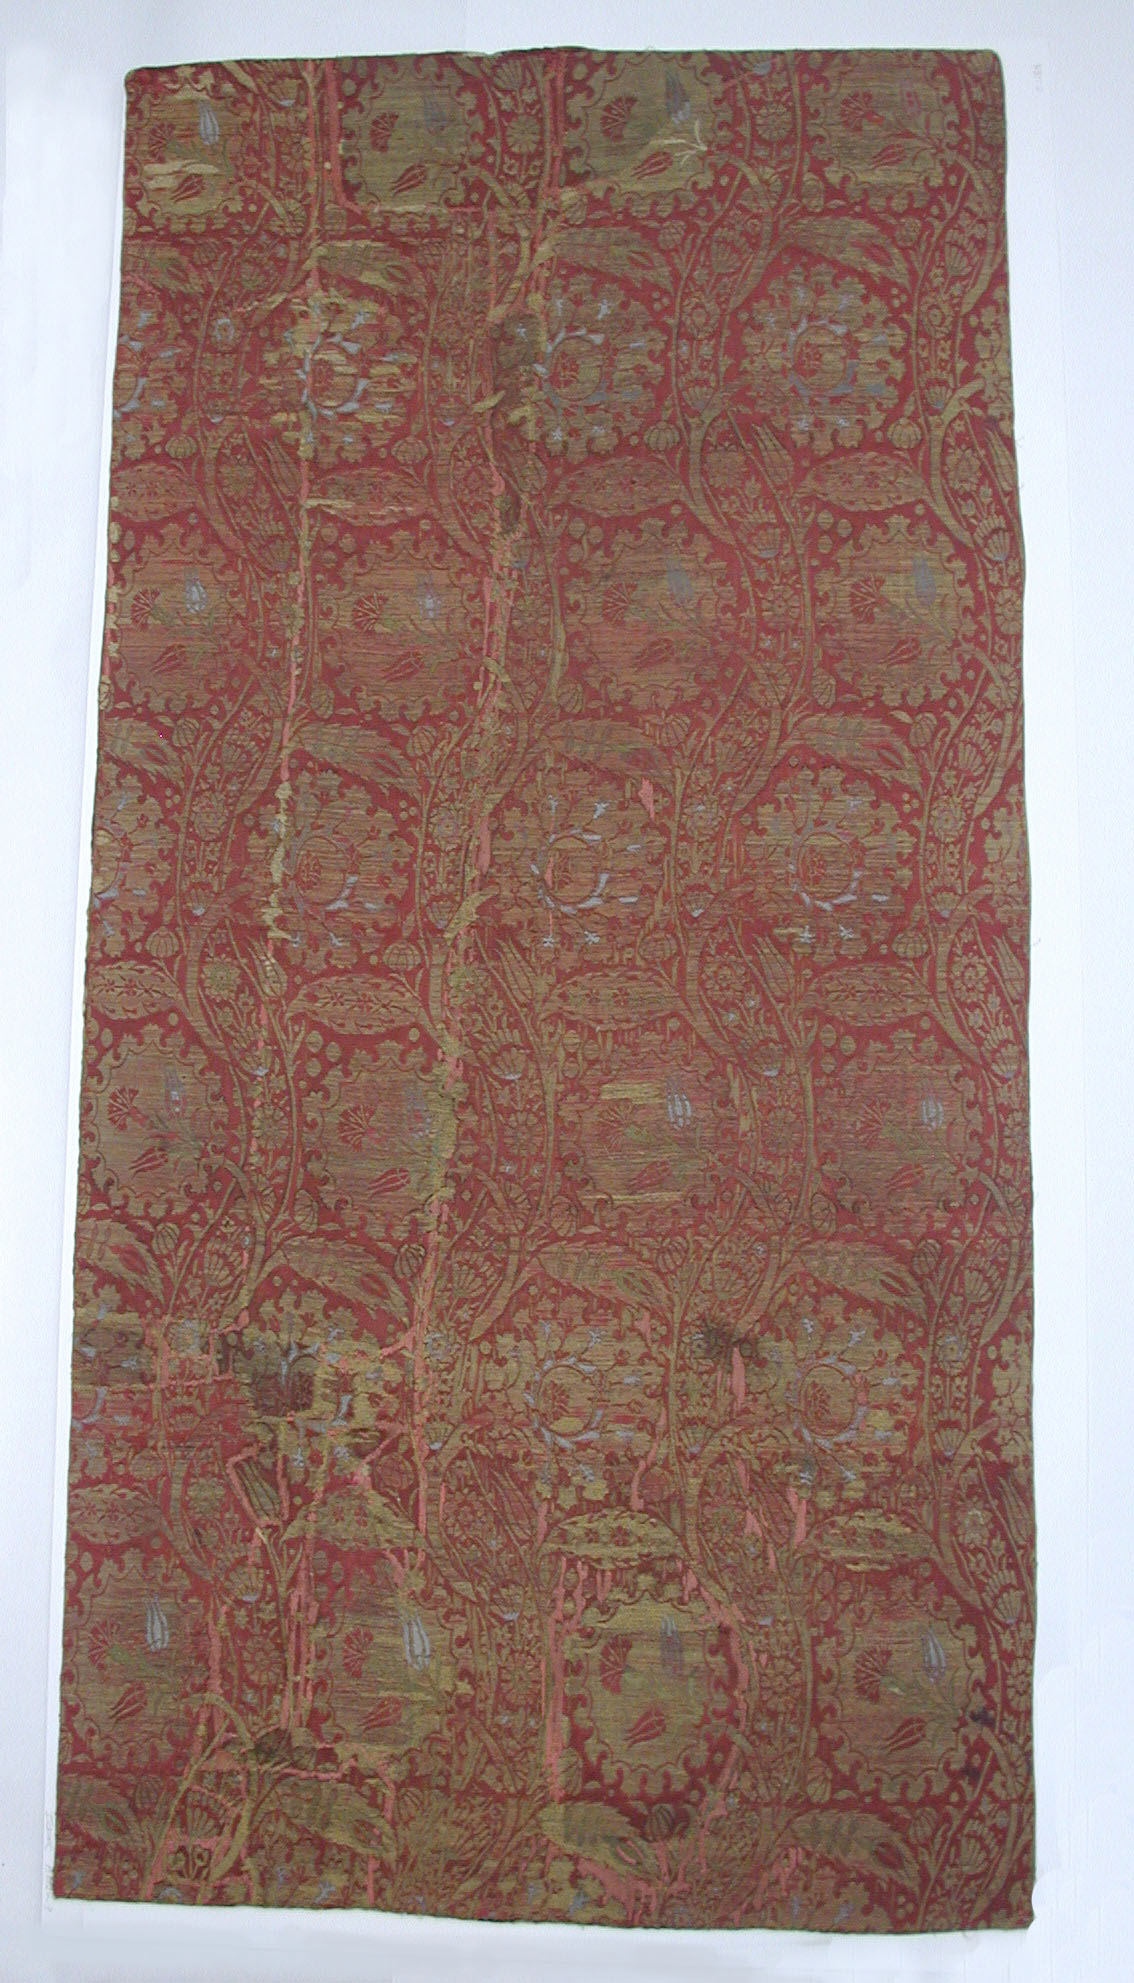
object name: panel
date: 1501-1600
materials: silk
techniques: brocade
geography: turkey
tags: flowers